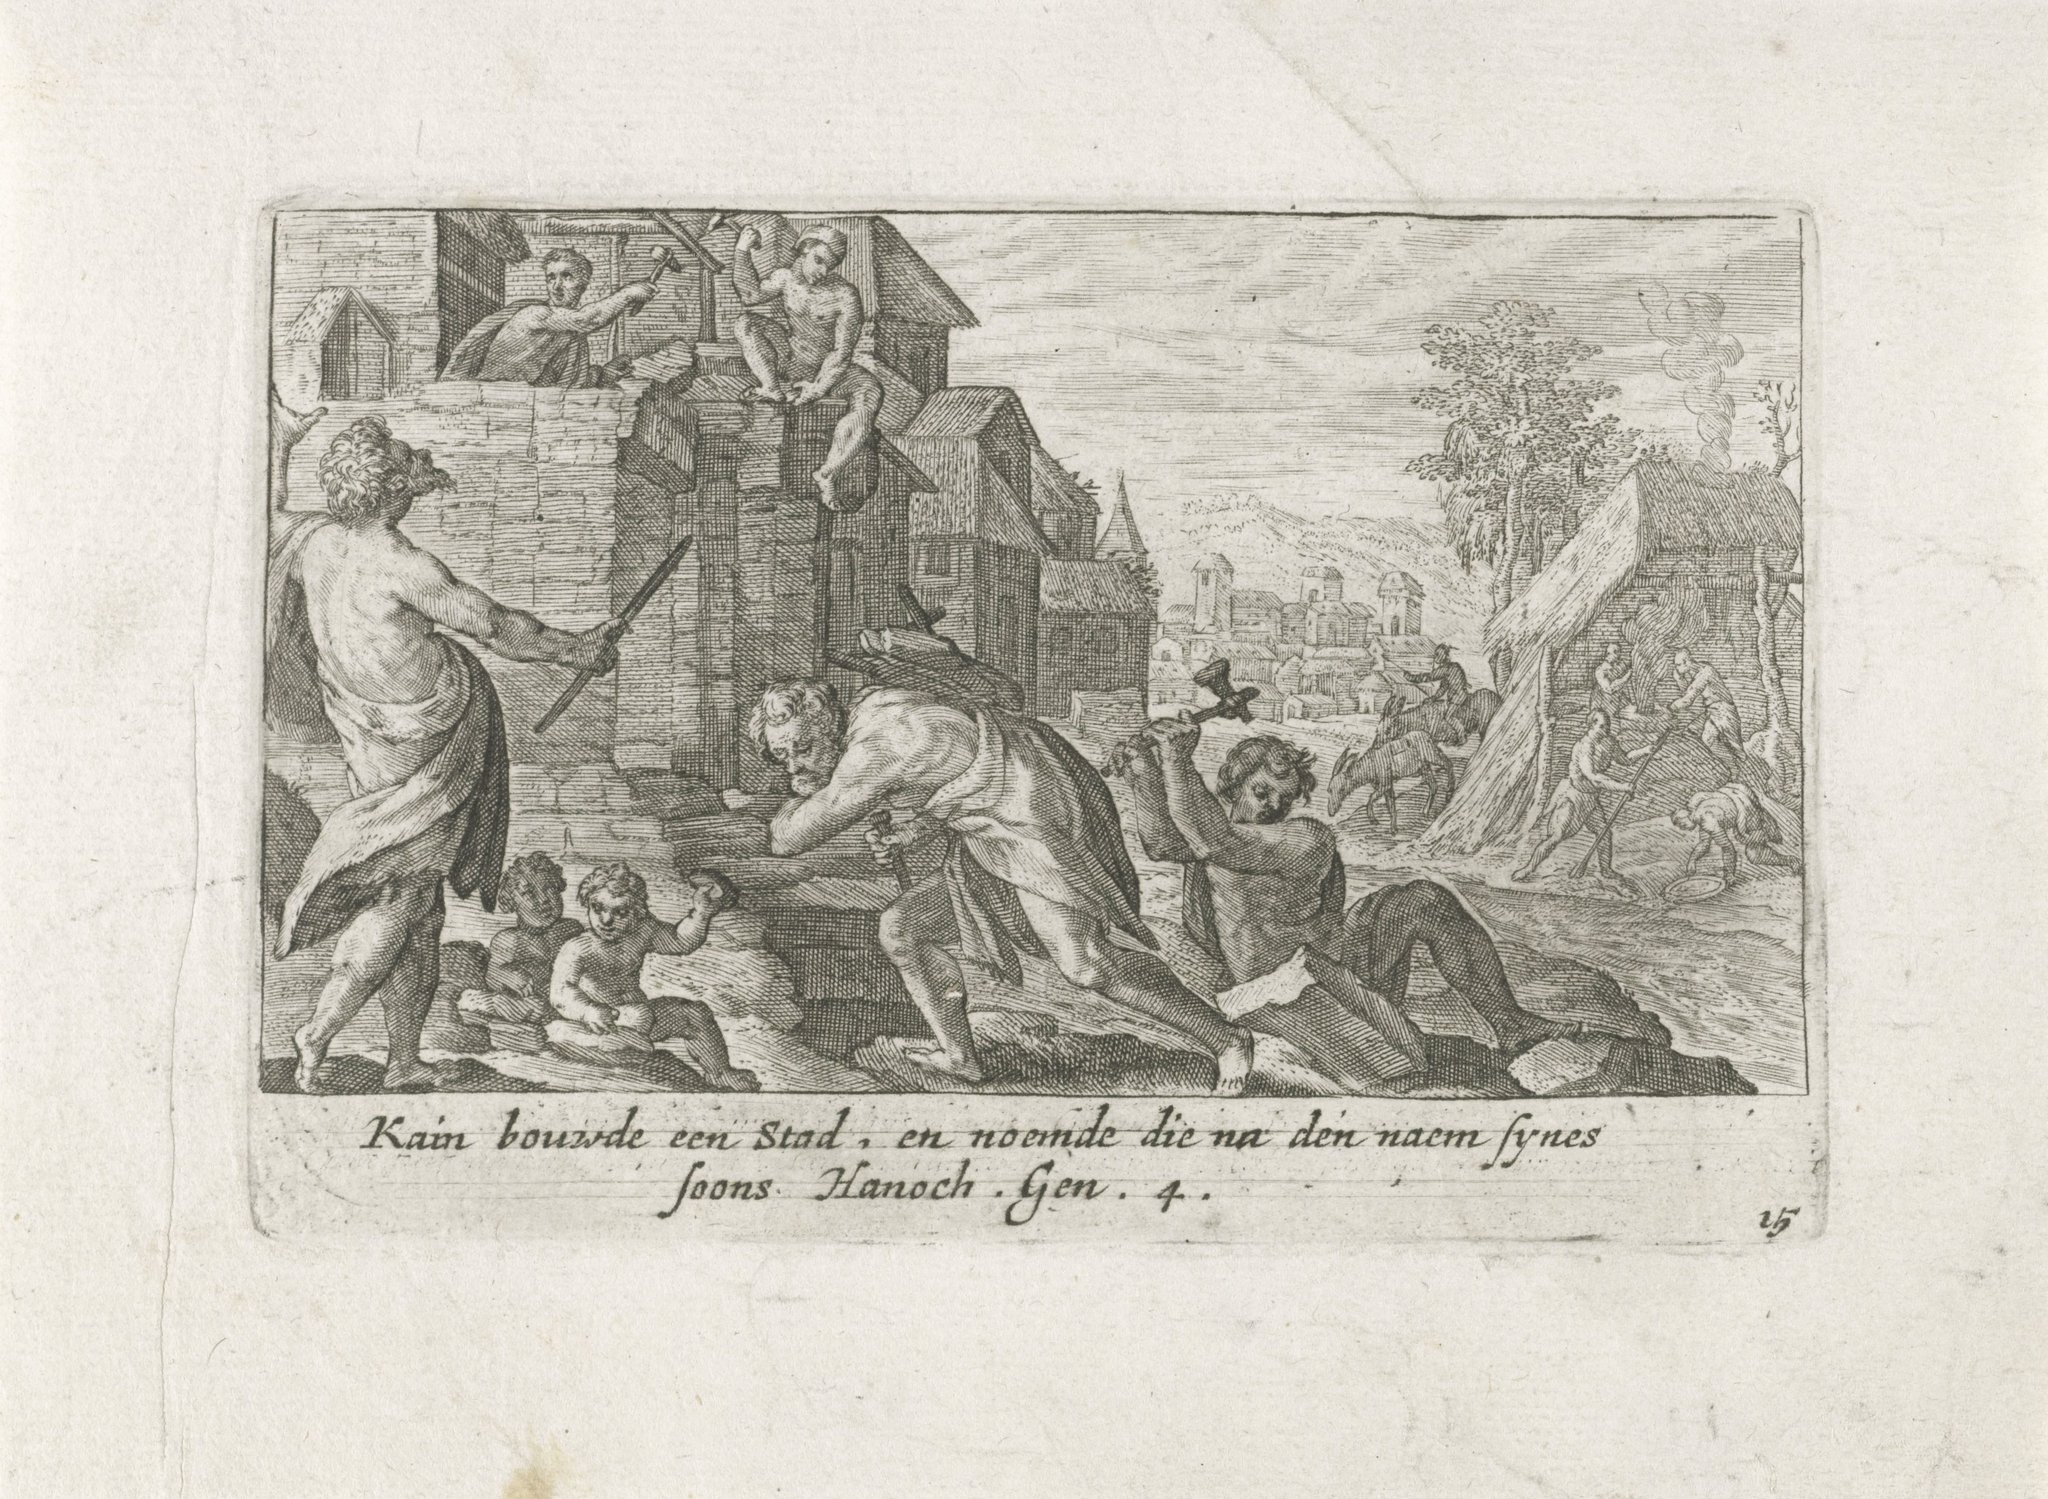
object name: print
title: Liber Genesis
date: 1700-1750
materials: paper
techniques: engraving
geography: amsterdam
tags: cain building the city of enoch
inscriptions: collector's mark: Lugt 2233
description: Kaïn bouwt een stad en noemt deze Henoch, naar zijn zoon. In de marge een tweeregelig onderschrift in het Nederlands.